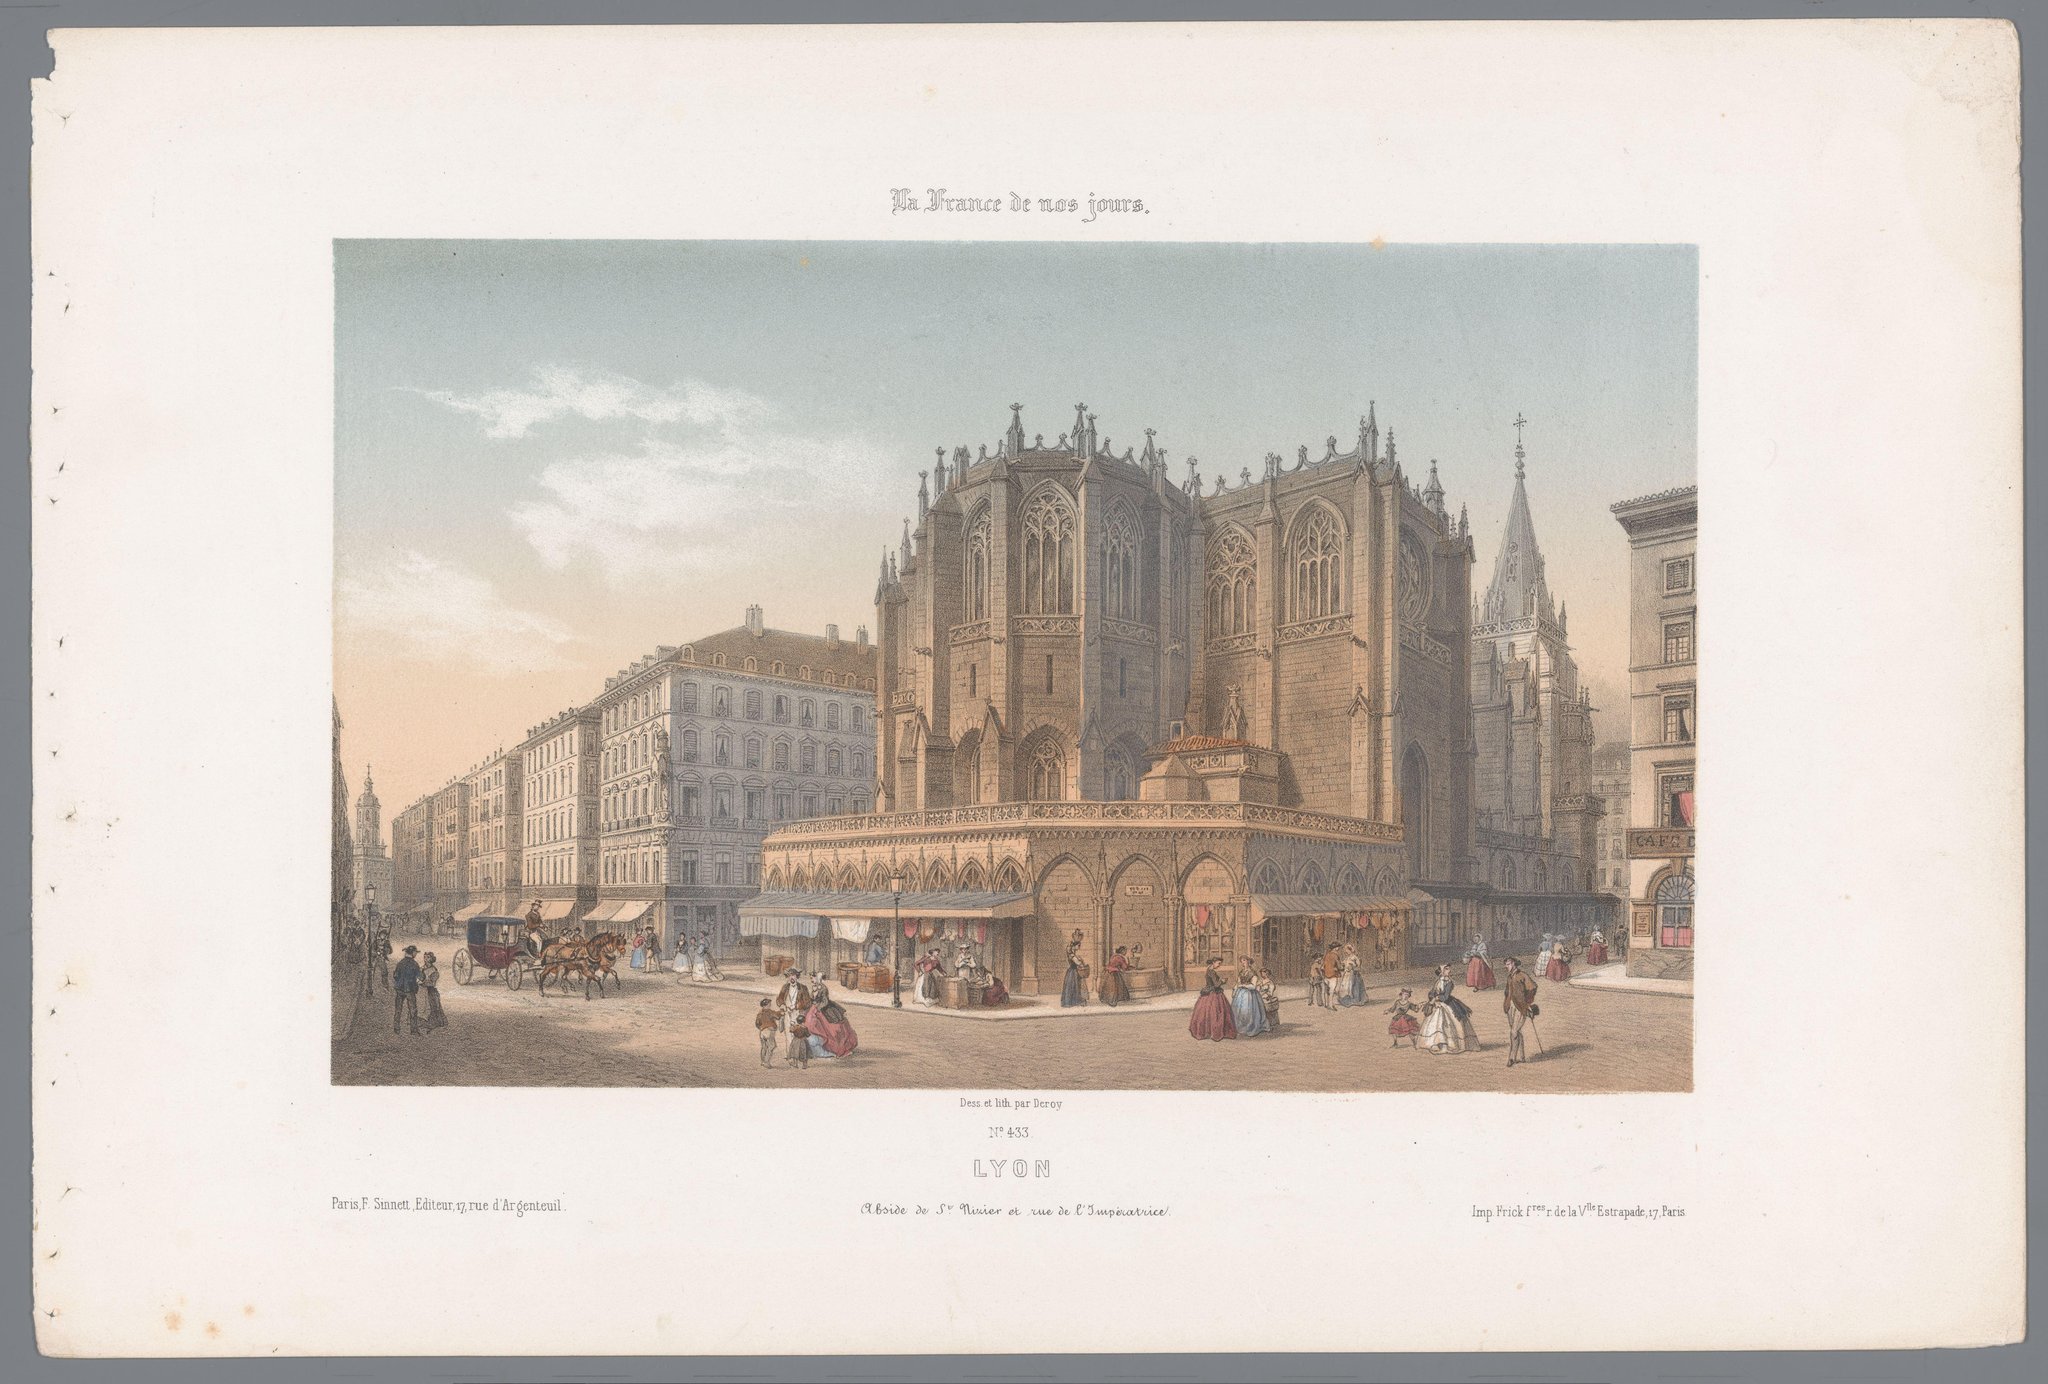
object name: print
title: Hedendaags Frankrijk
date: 1861-1872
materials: paper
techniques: hand coloring, iris print, lithograph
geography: paris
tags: church (exterior), street (+ city(-scape) with figures, staffage)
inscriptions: collector's mark: Lugt 2228a